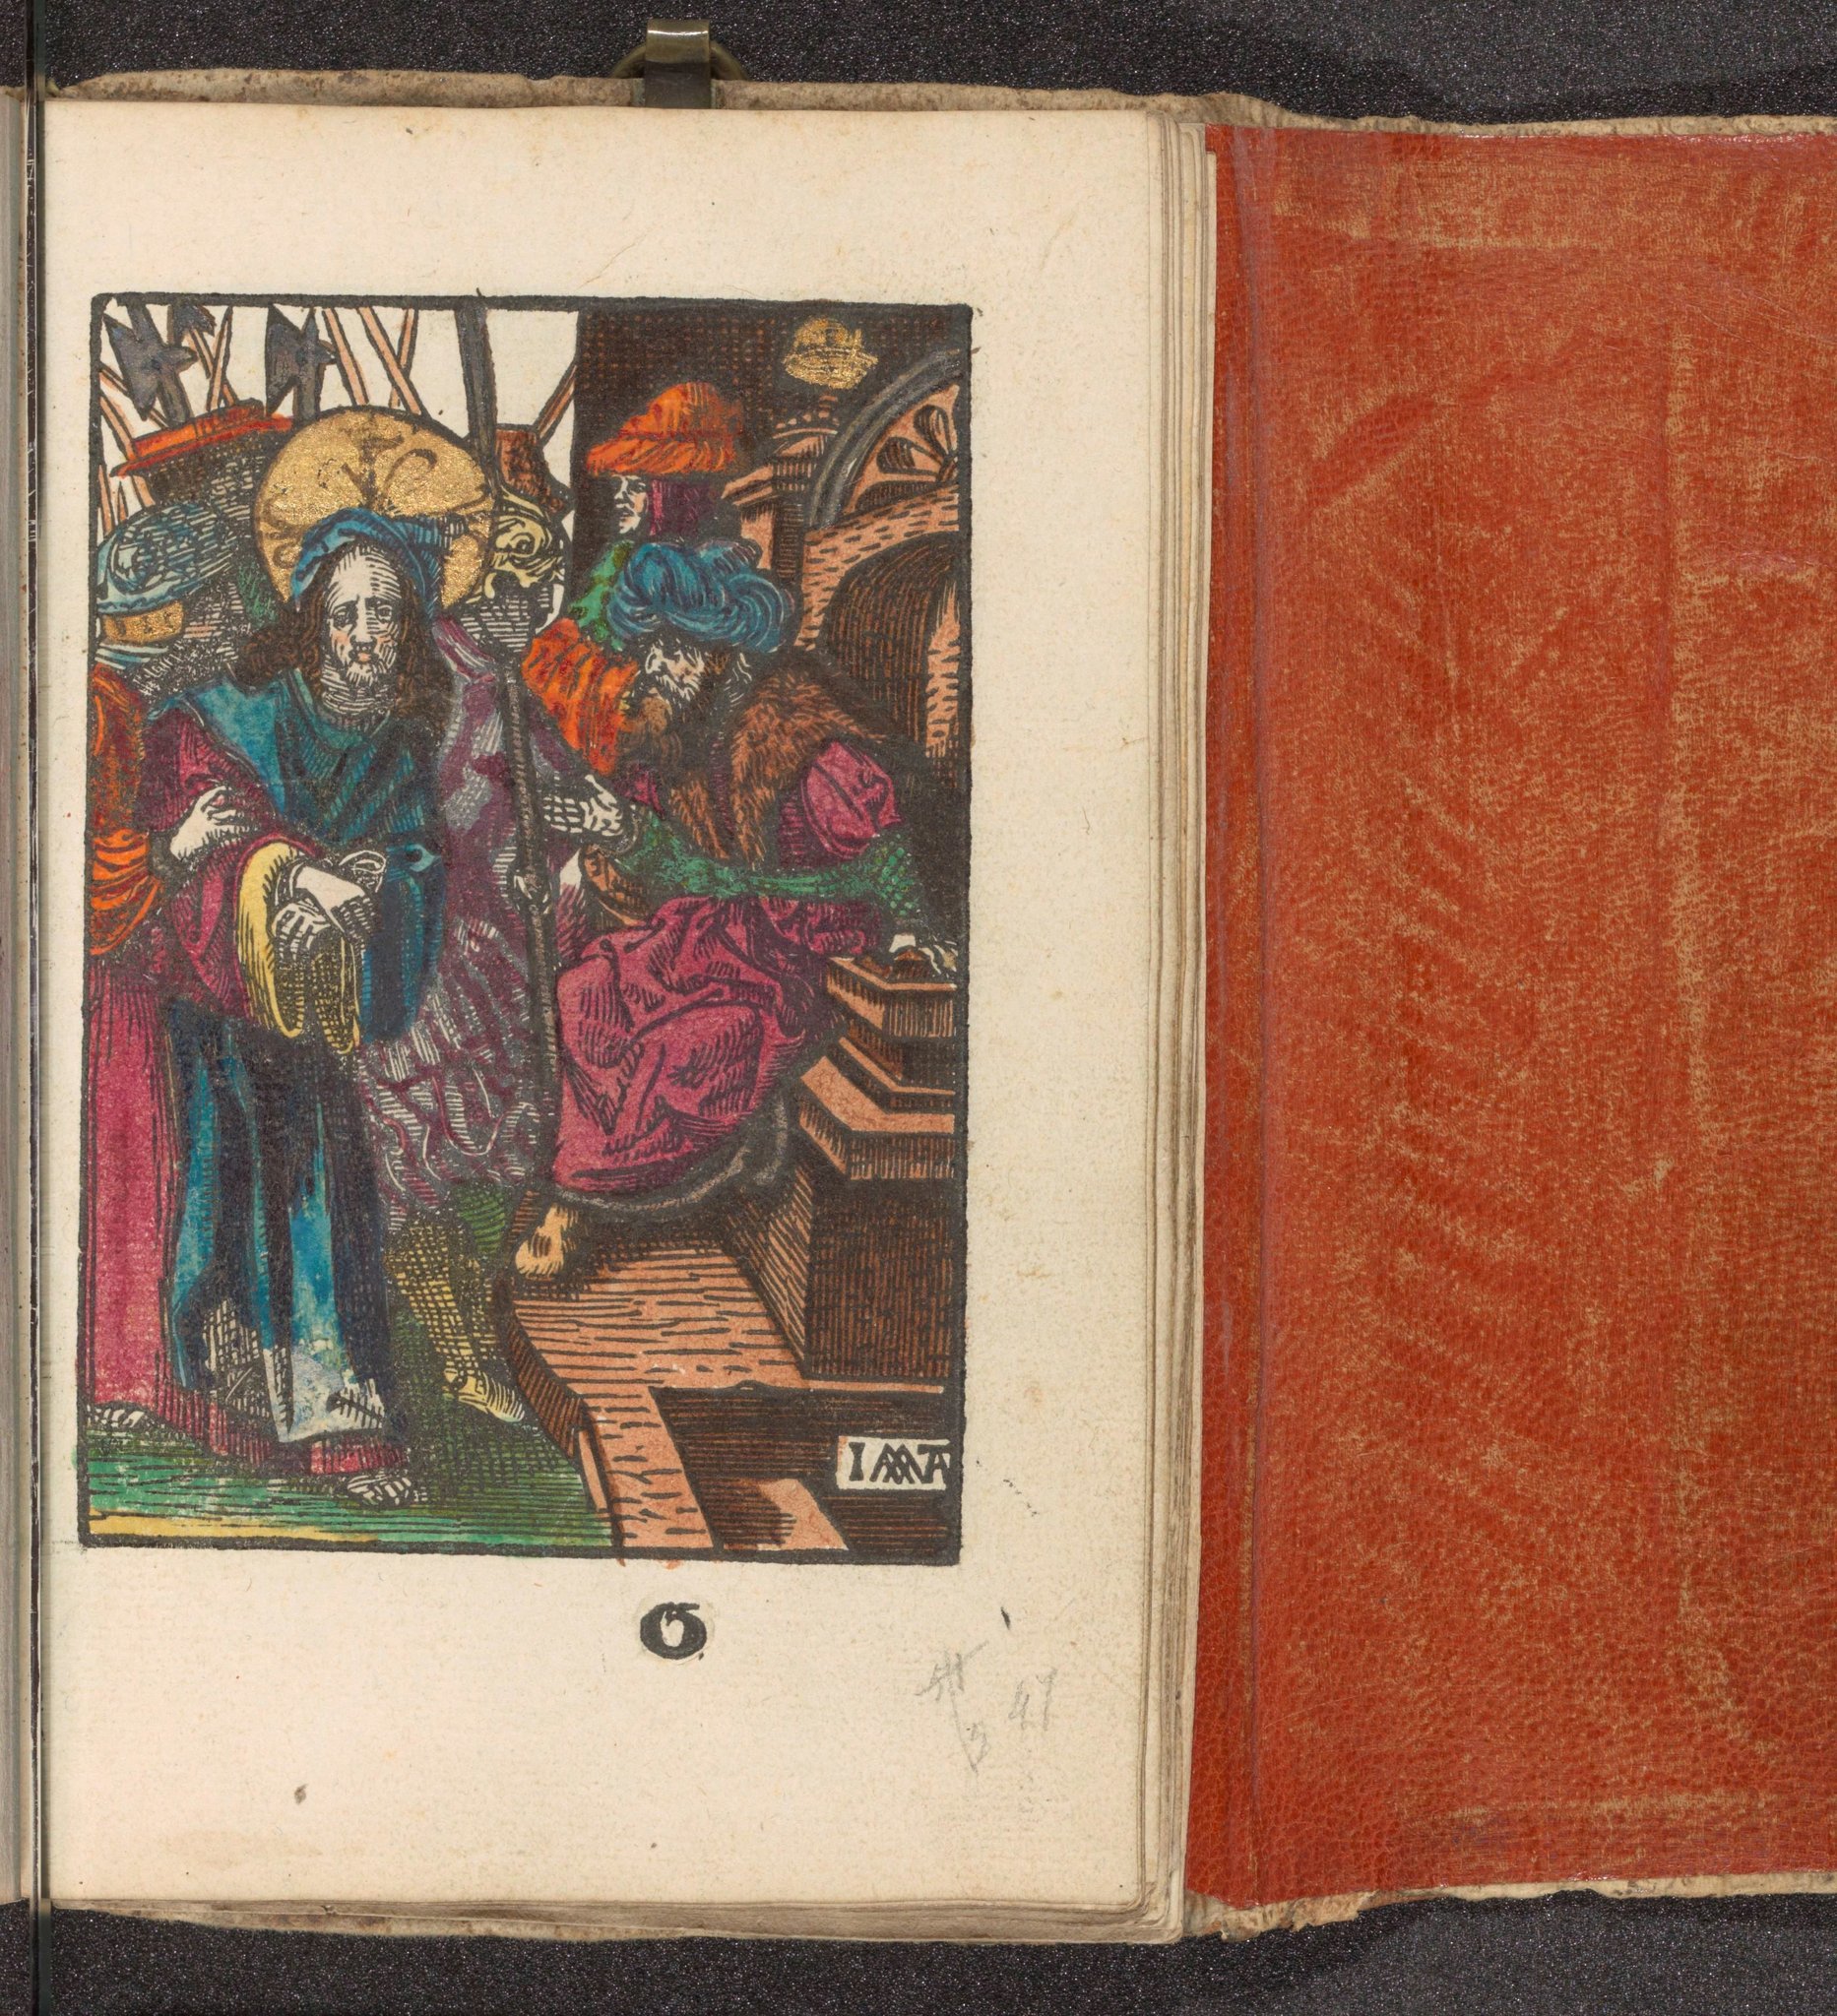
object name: print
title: Stomme Passie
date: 1520-1521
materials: paper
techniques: hand coloring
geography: amsterdam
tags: christ before pontius pilate (matthew 27:11-26; mark 15:2-15; luke 23:2-7, 23:13-25; john 18:28 - 19:16), book in which illustrations are essential, christ brought from one judge to another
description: Soldaten leiden Christus weg van Pilatus. Onderaan gemerkt: G. Prent maakt deel uit van een boek.